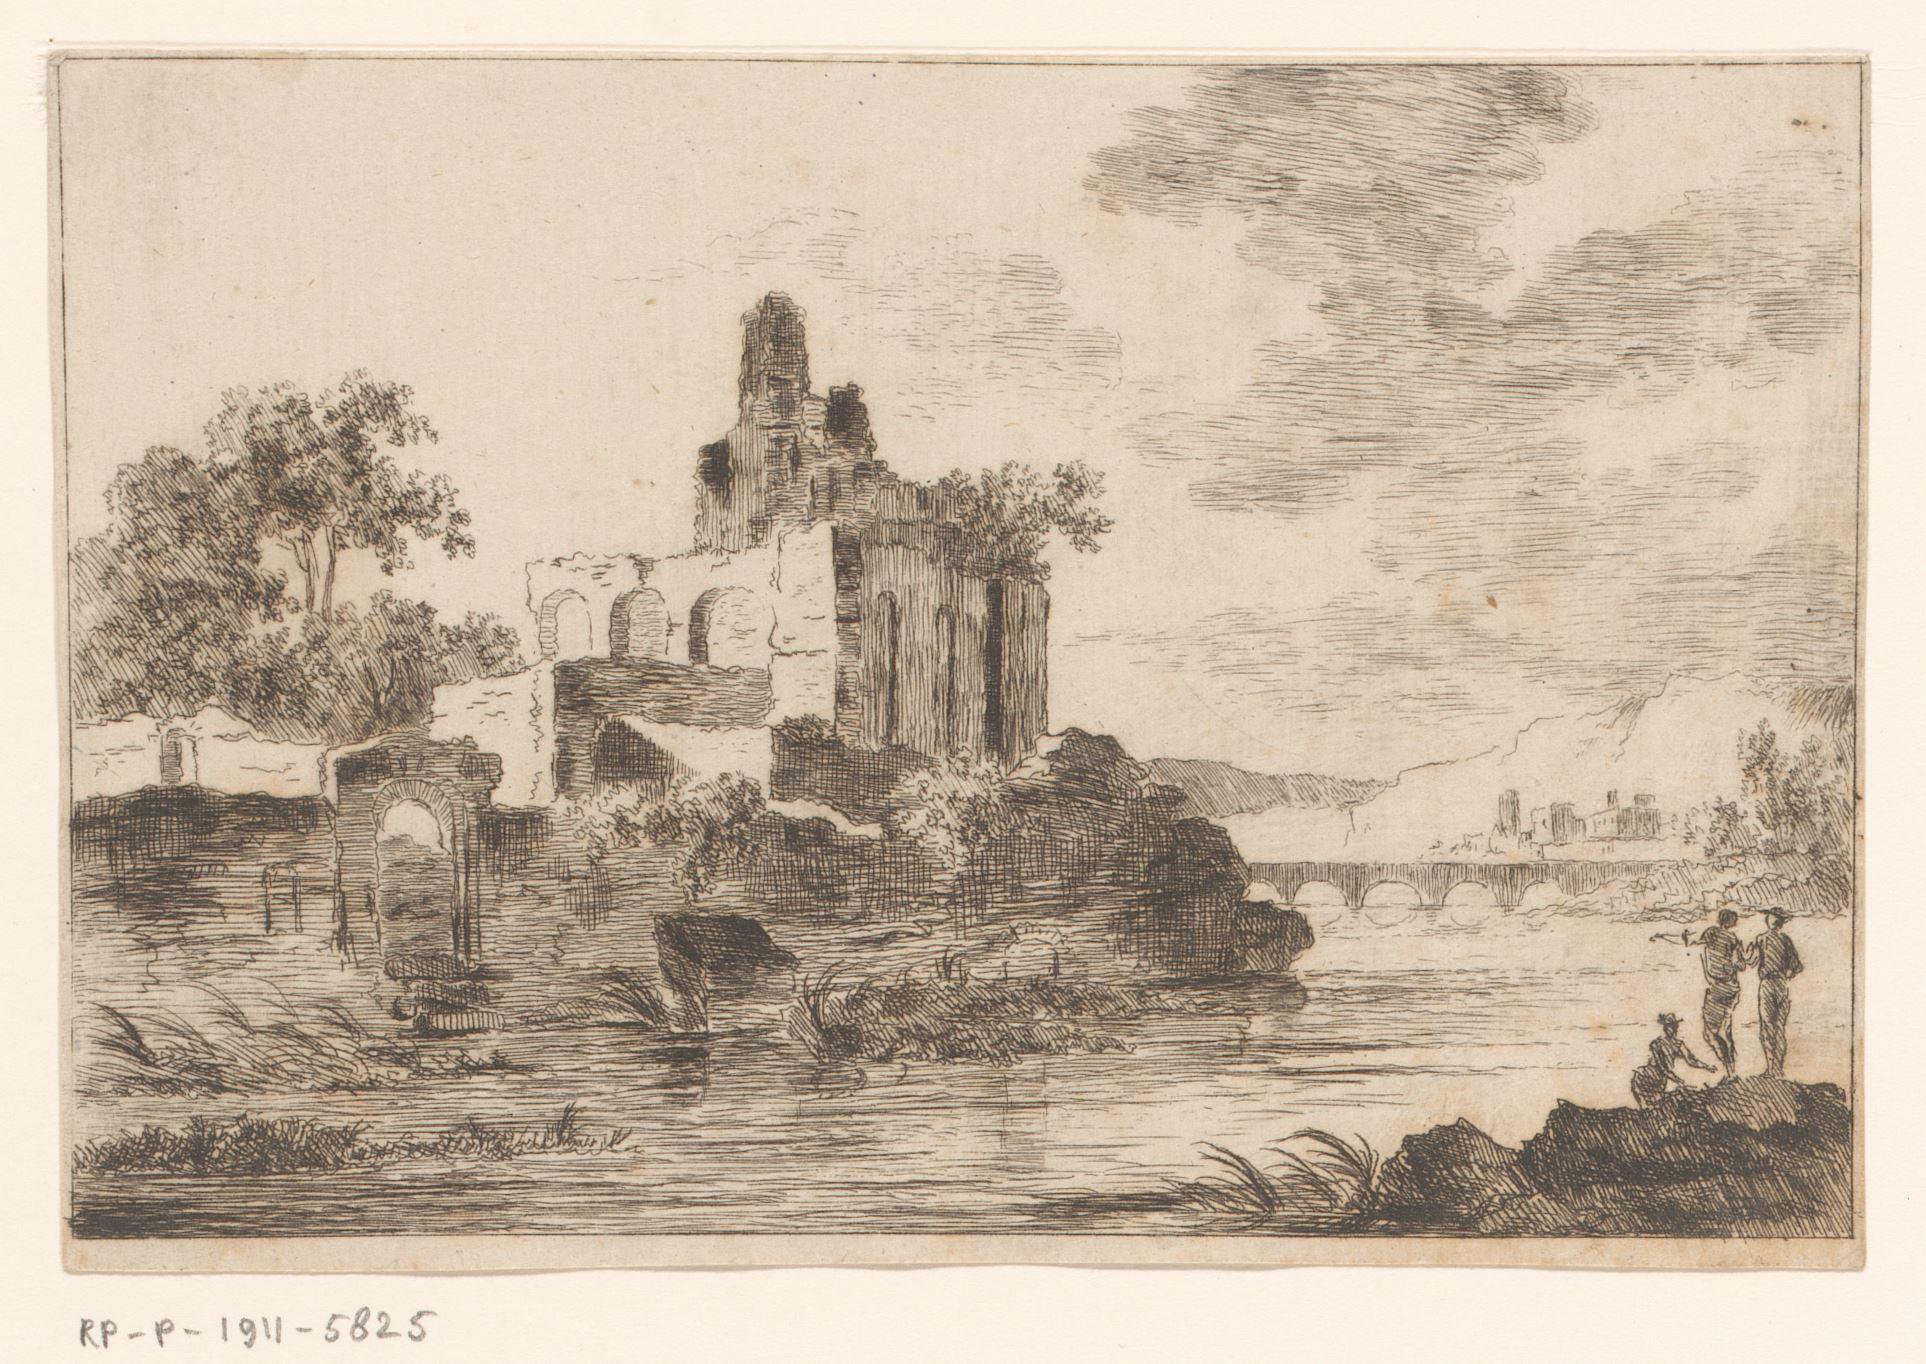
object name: print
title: Rivierlandschap met een ruïne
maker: sauveur legros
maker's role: print maker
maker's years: 1754-1834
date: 1764-1834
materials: paper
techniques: etching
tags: river, landscape with bridge, viaduct or aqueduct, landscape with ruins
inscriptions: collector's mark: Lugt 2228